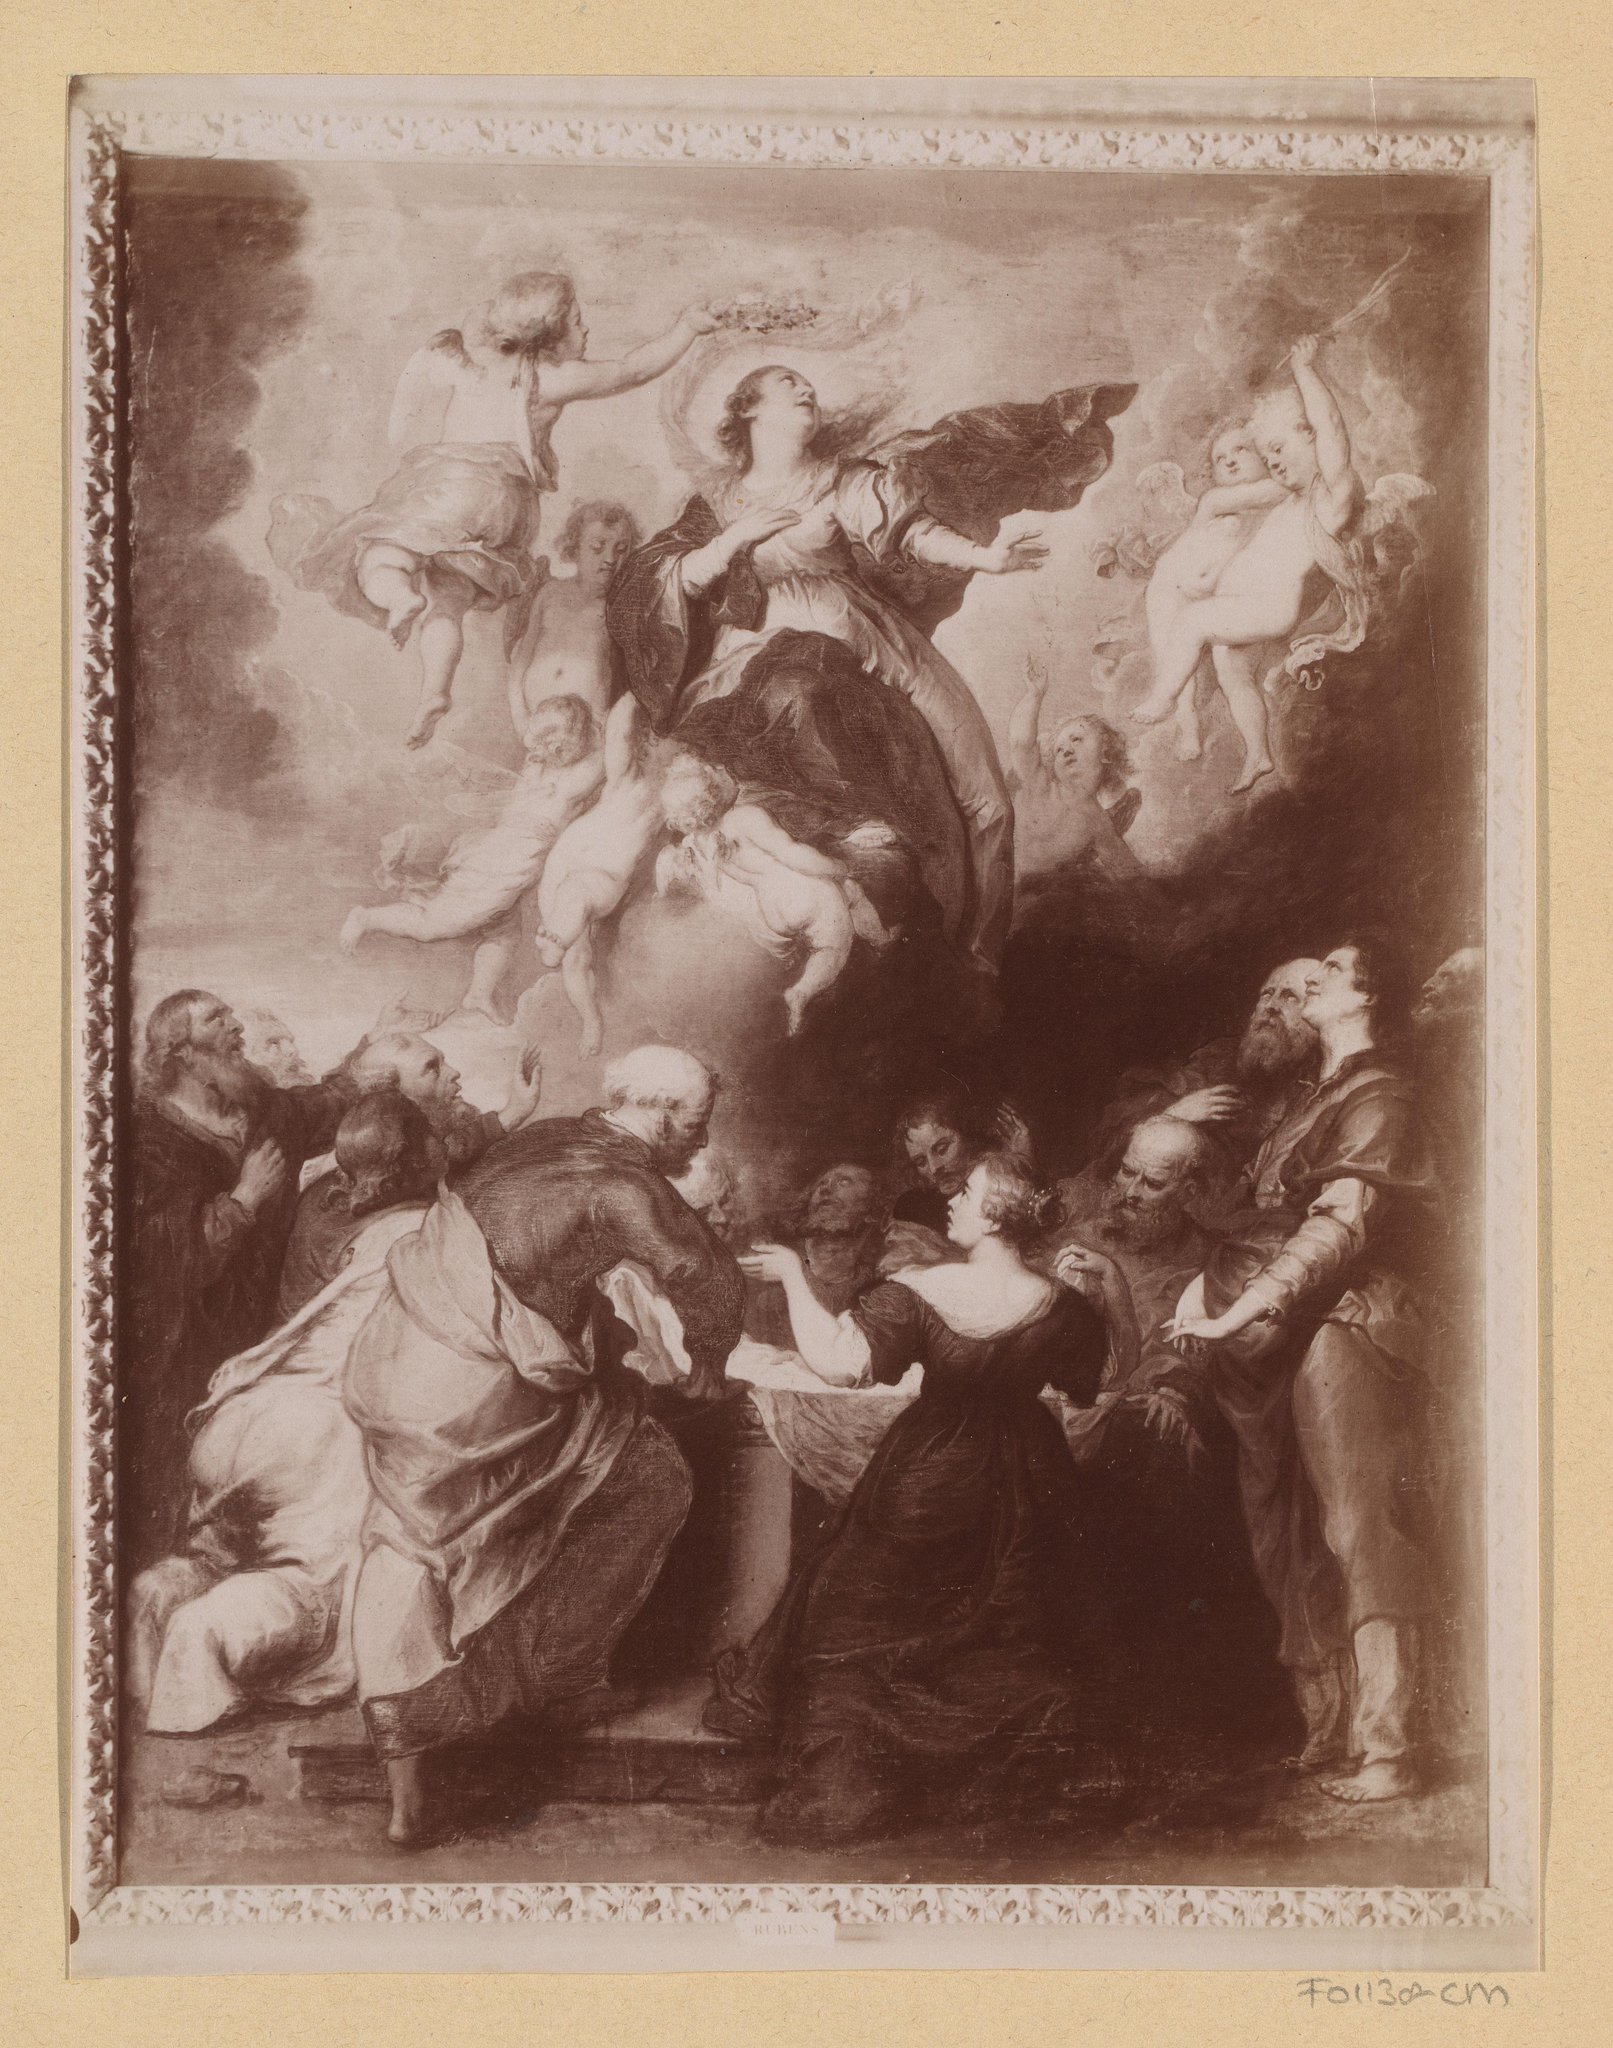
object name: photograph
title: Fotoreproductie van (vermoedelijk) een schilderij, voorstellend de Hemelvaart van Maria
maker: Anonymous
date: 1860-1900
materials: photographic support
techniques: albumen print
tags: the assumption of mary ('assumptio corporis'): she is borne into heaven by angels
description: Onderdeel van Reisalbum met opnames van kunstwerken en bezienswaardigheden in Italië, Griekenland en Frankrijk.